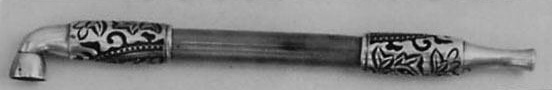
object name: pipe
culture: japanese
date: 1801-1900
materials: silver